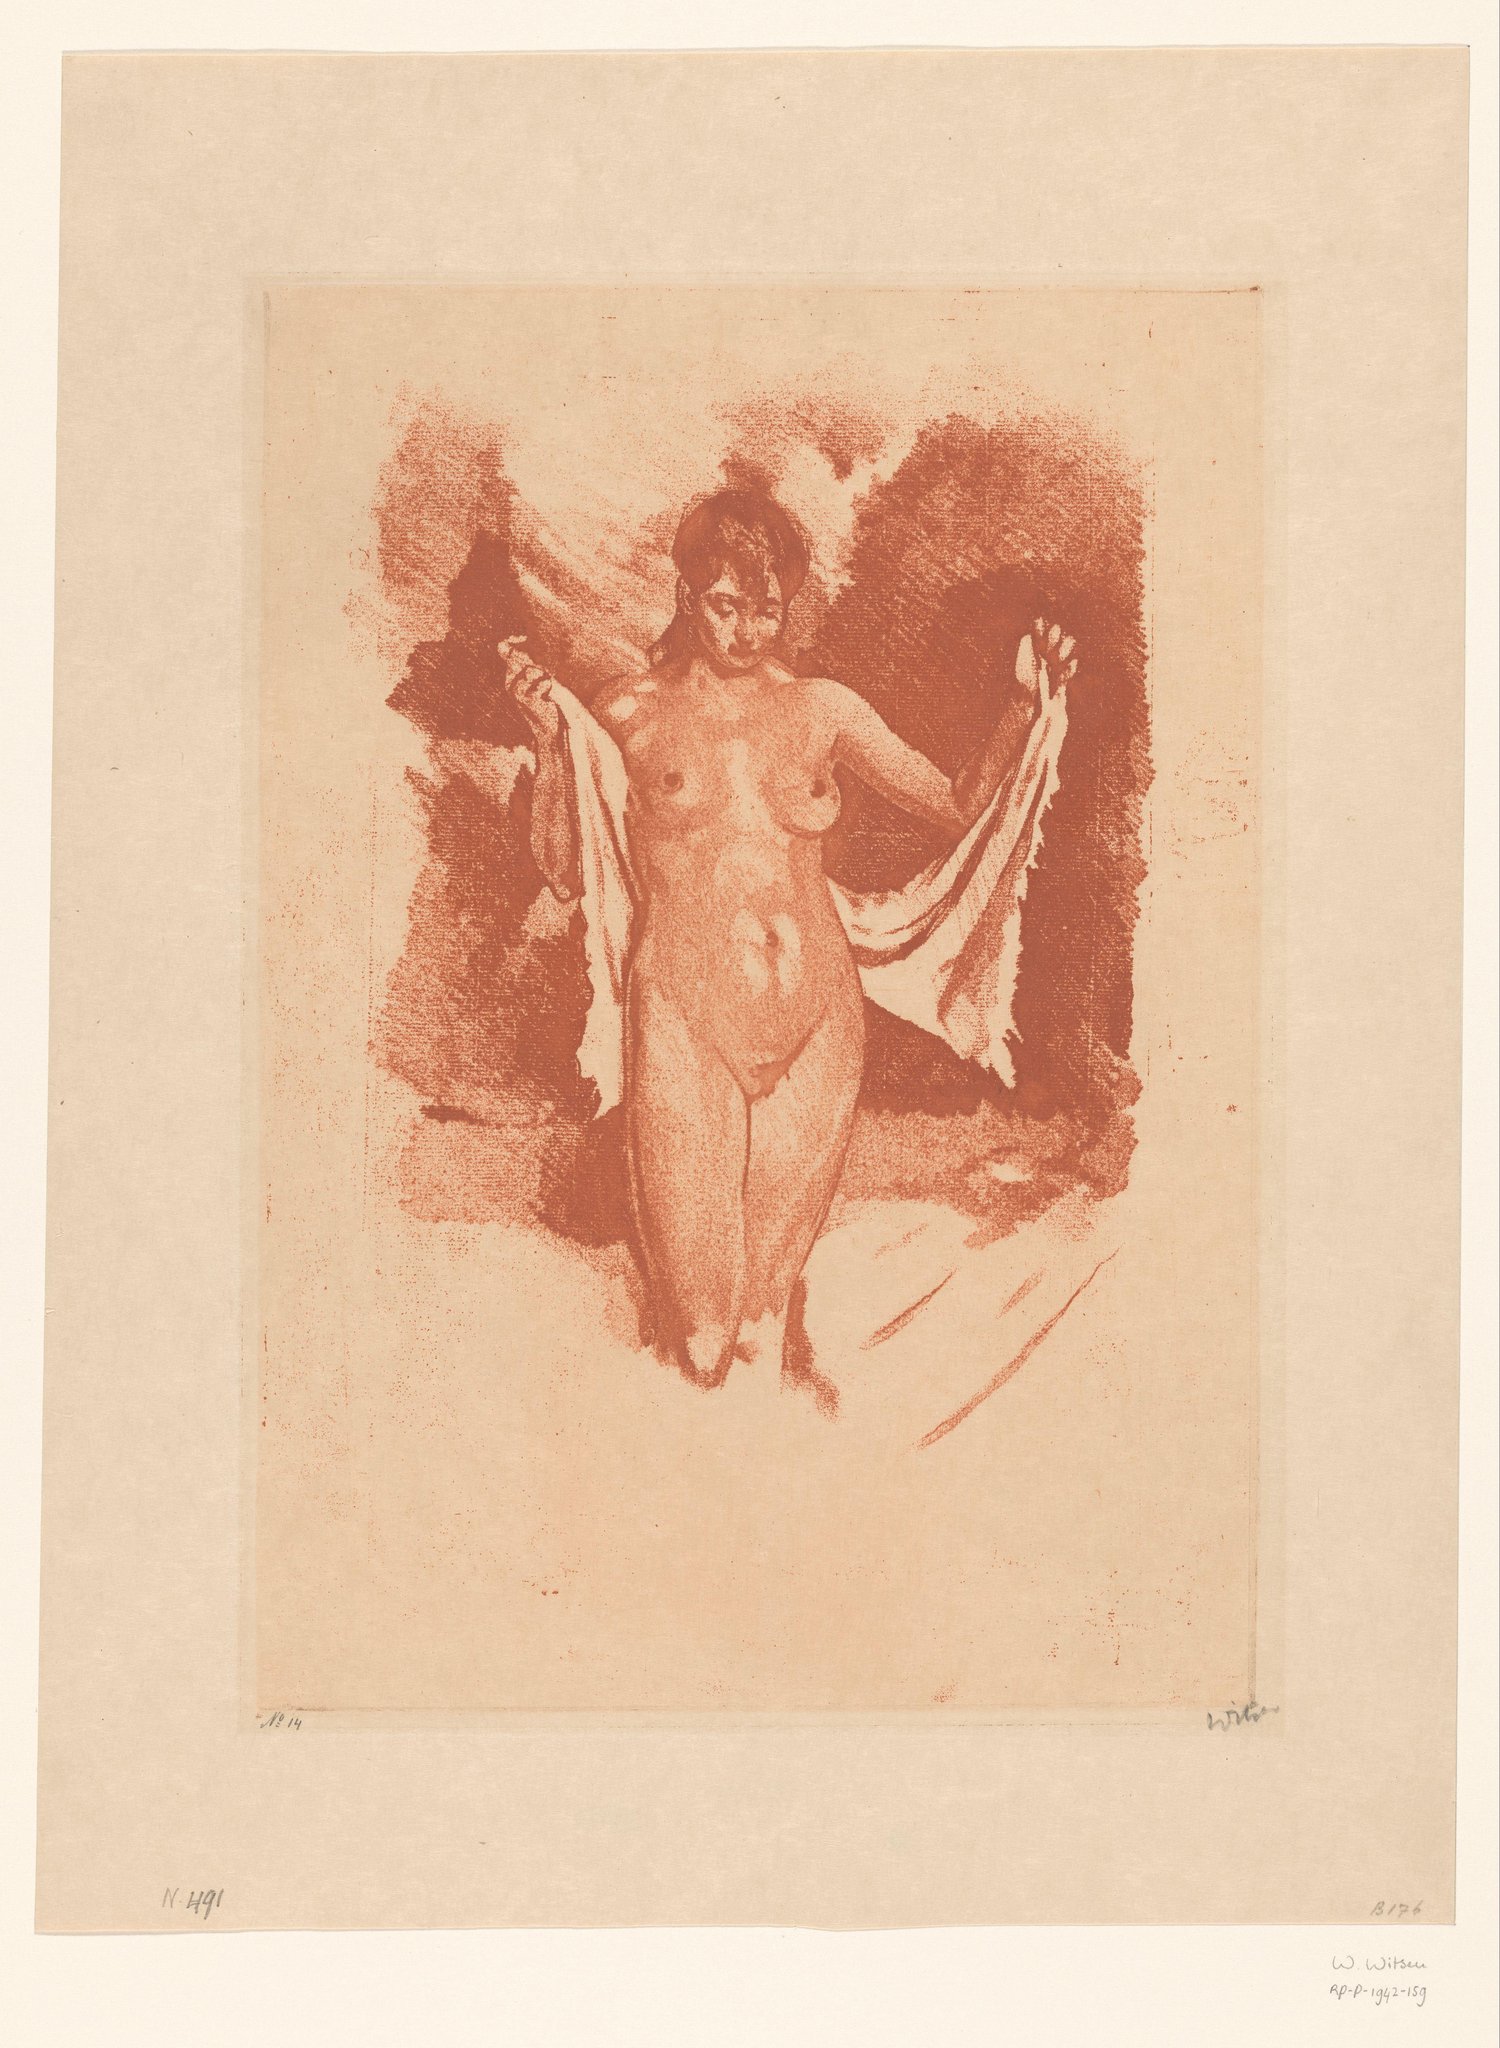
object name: print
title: Staande, naakte vrouw die zich afdroogt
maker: willem witsen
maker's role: draughtsman, painter, print maker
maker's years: 1860-1923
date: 1919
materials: paper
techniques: soft ground etching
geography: amsterdam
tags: care of the body, hygiene, towel, the (nude) human figure; 'corpo humano' (ripa) - aa - female human figure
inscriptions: collector's mark: Lugt 2760, inscription: ‘No. 14’, collector's mark: Lugt 2228